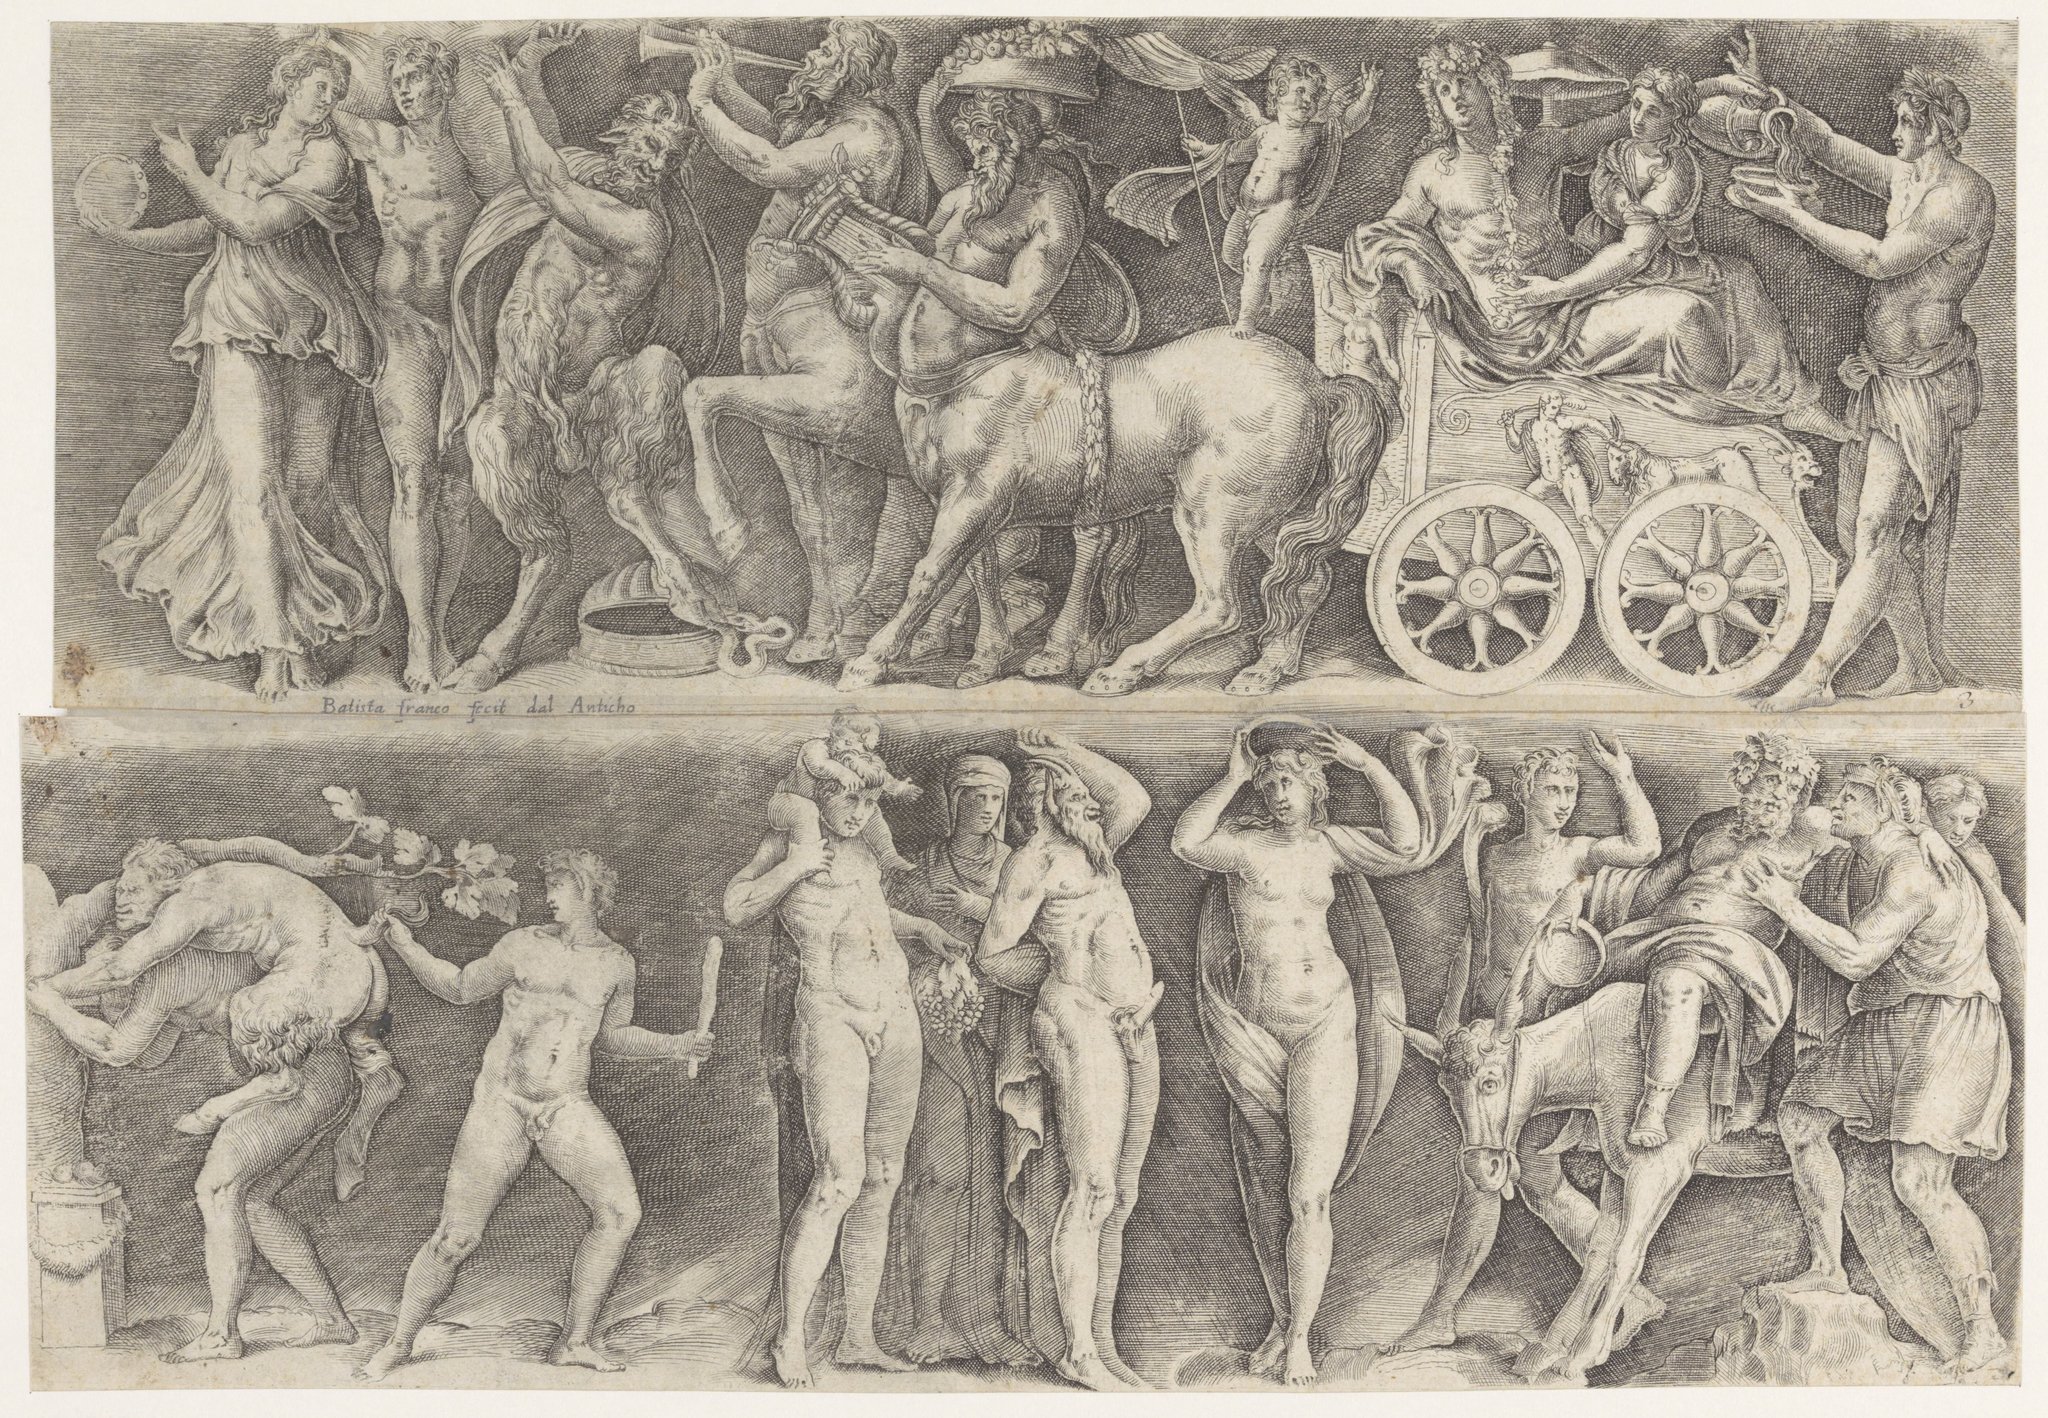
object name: print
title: Antiek reliëf met Bacchus en Ariadne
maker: battista franco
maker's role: draughtsman, painter, print maker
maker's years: 1510-1561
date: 1520-1561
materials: paper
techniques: engraving, etching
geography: italy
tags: triumph of bacchus and ariadne, (story of) ariadne and bacchus, (story of) ariadne, satyr(s) (in general)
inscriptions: number: ‘1’, number: ‘3’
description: Boven: Bacchus en Ariadne op een triomfwagen die wordt voortgetrokken door twee centauren. Voor de wagen lopen een sater, een bacchante en een naakte man. Onder: de dronken Silenus op een ezel, saters, een bacchante en naakte figuren.